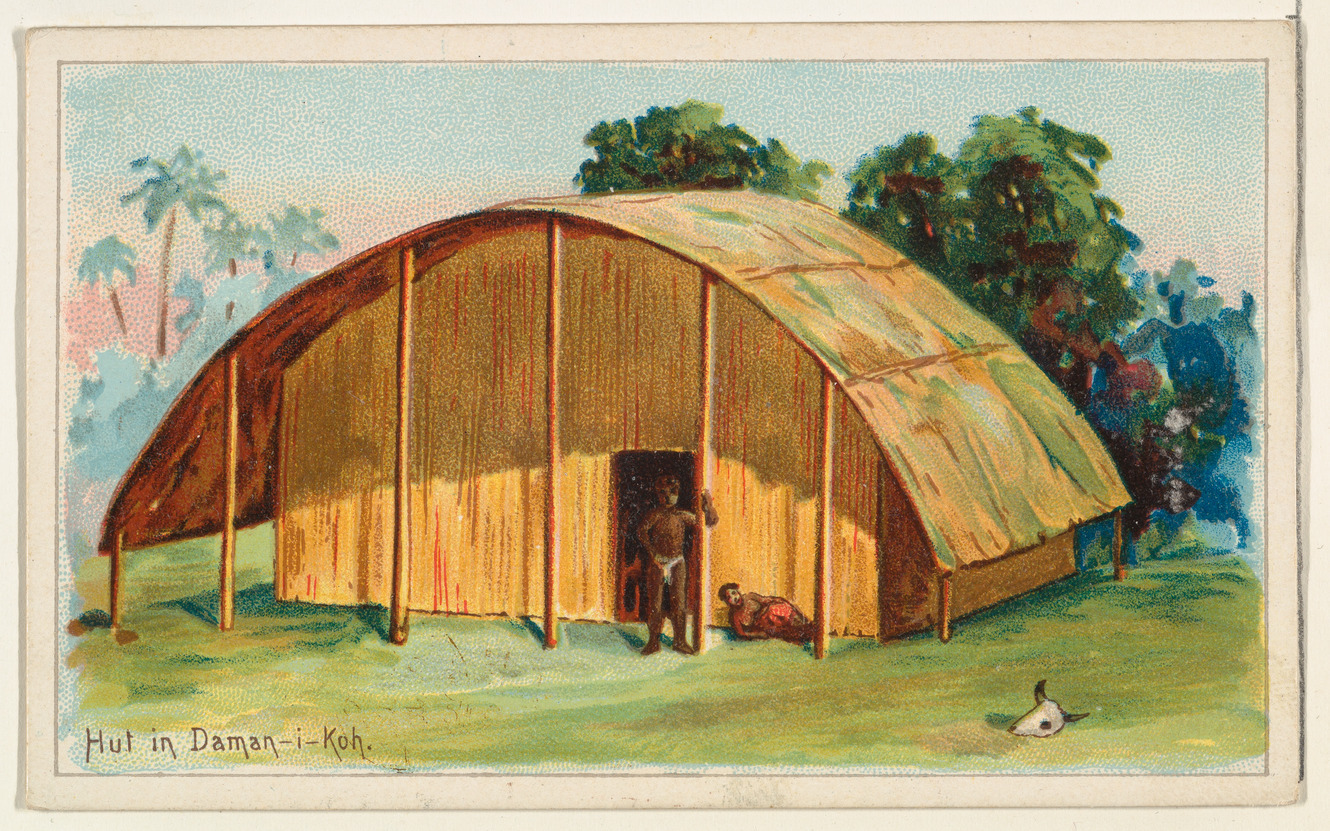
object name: print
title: Hut in Daman-i-koh, from the Habitations of Man series (N113) issued by W. Duke, Sons & Co. to promote Honest Long Cut Smoking and Chewing Tobacco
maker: the giles company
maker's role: artist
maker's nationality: american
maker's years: 1800-1900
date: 1890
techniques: color lithograph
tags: houses,boys